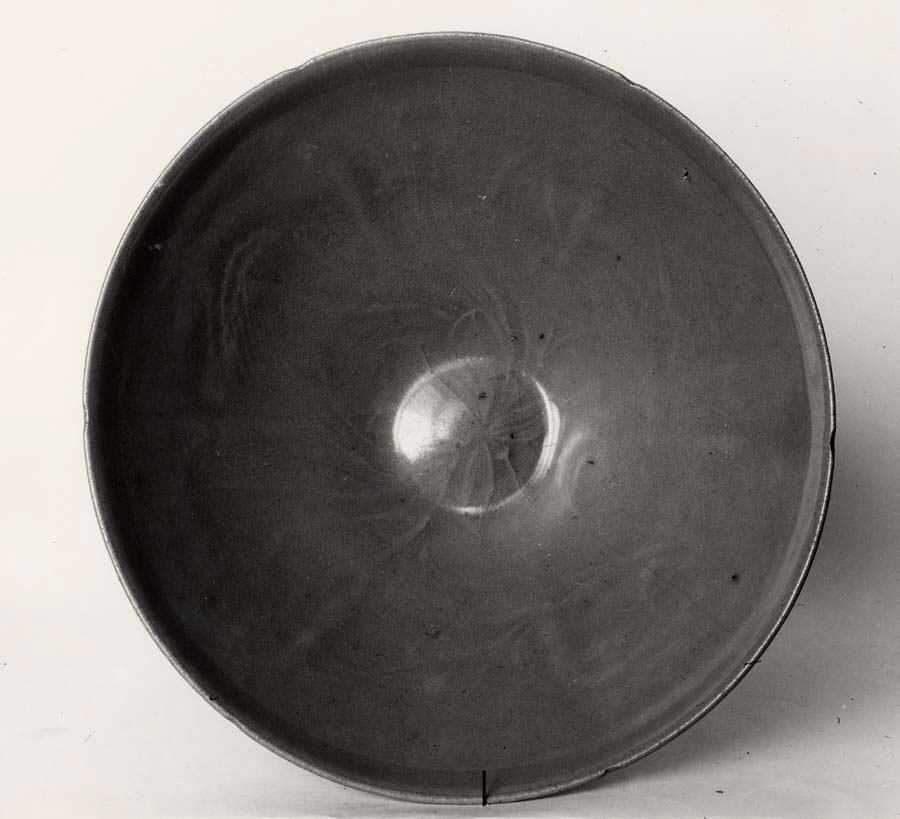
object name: bowl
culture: korean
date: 918-1392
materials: clay